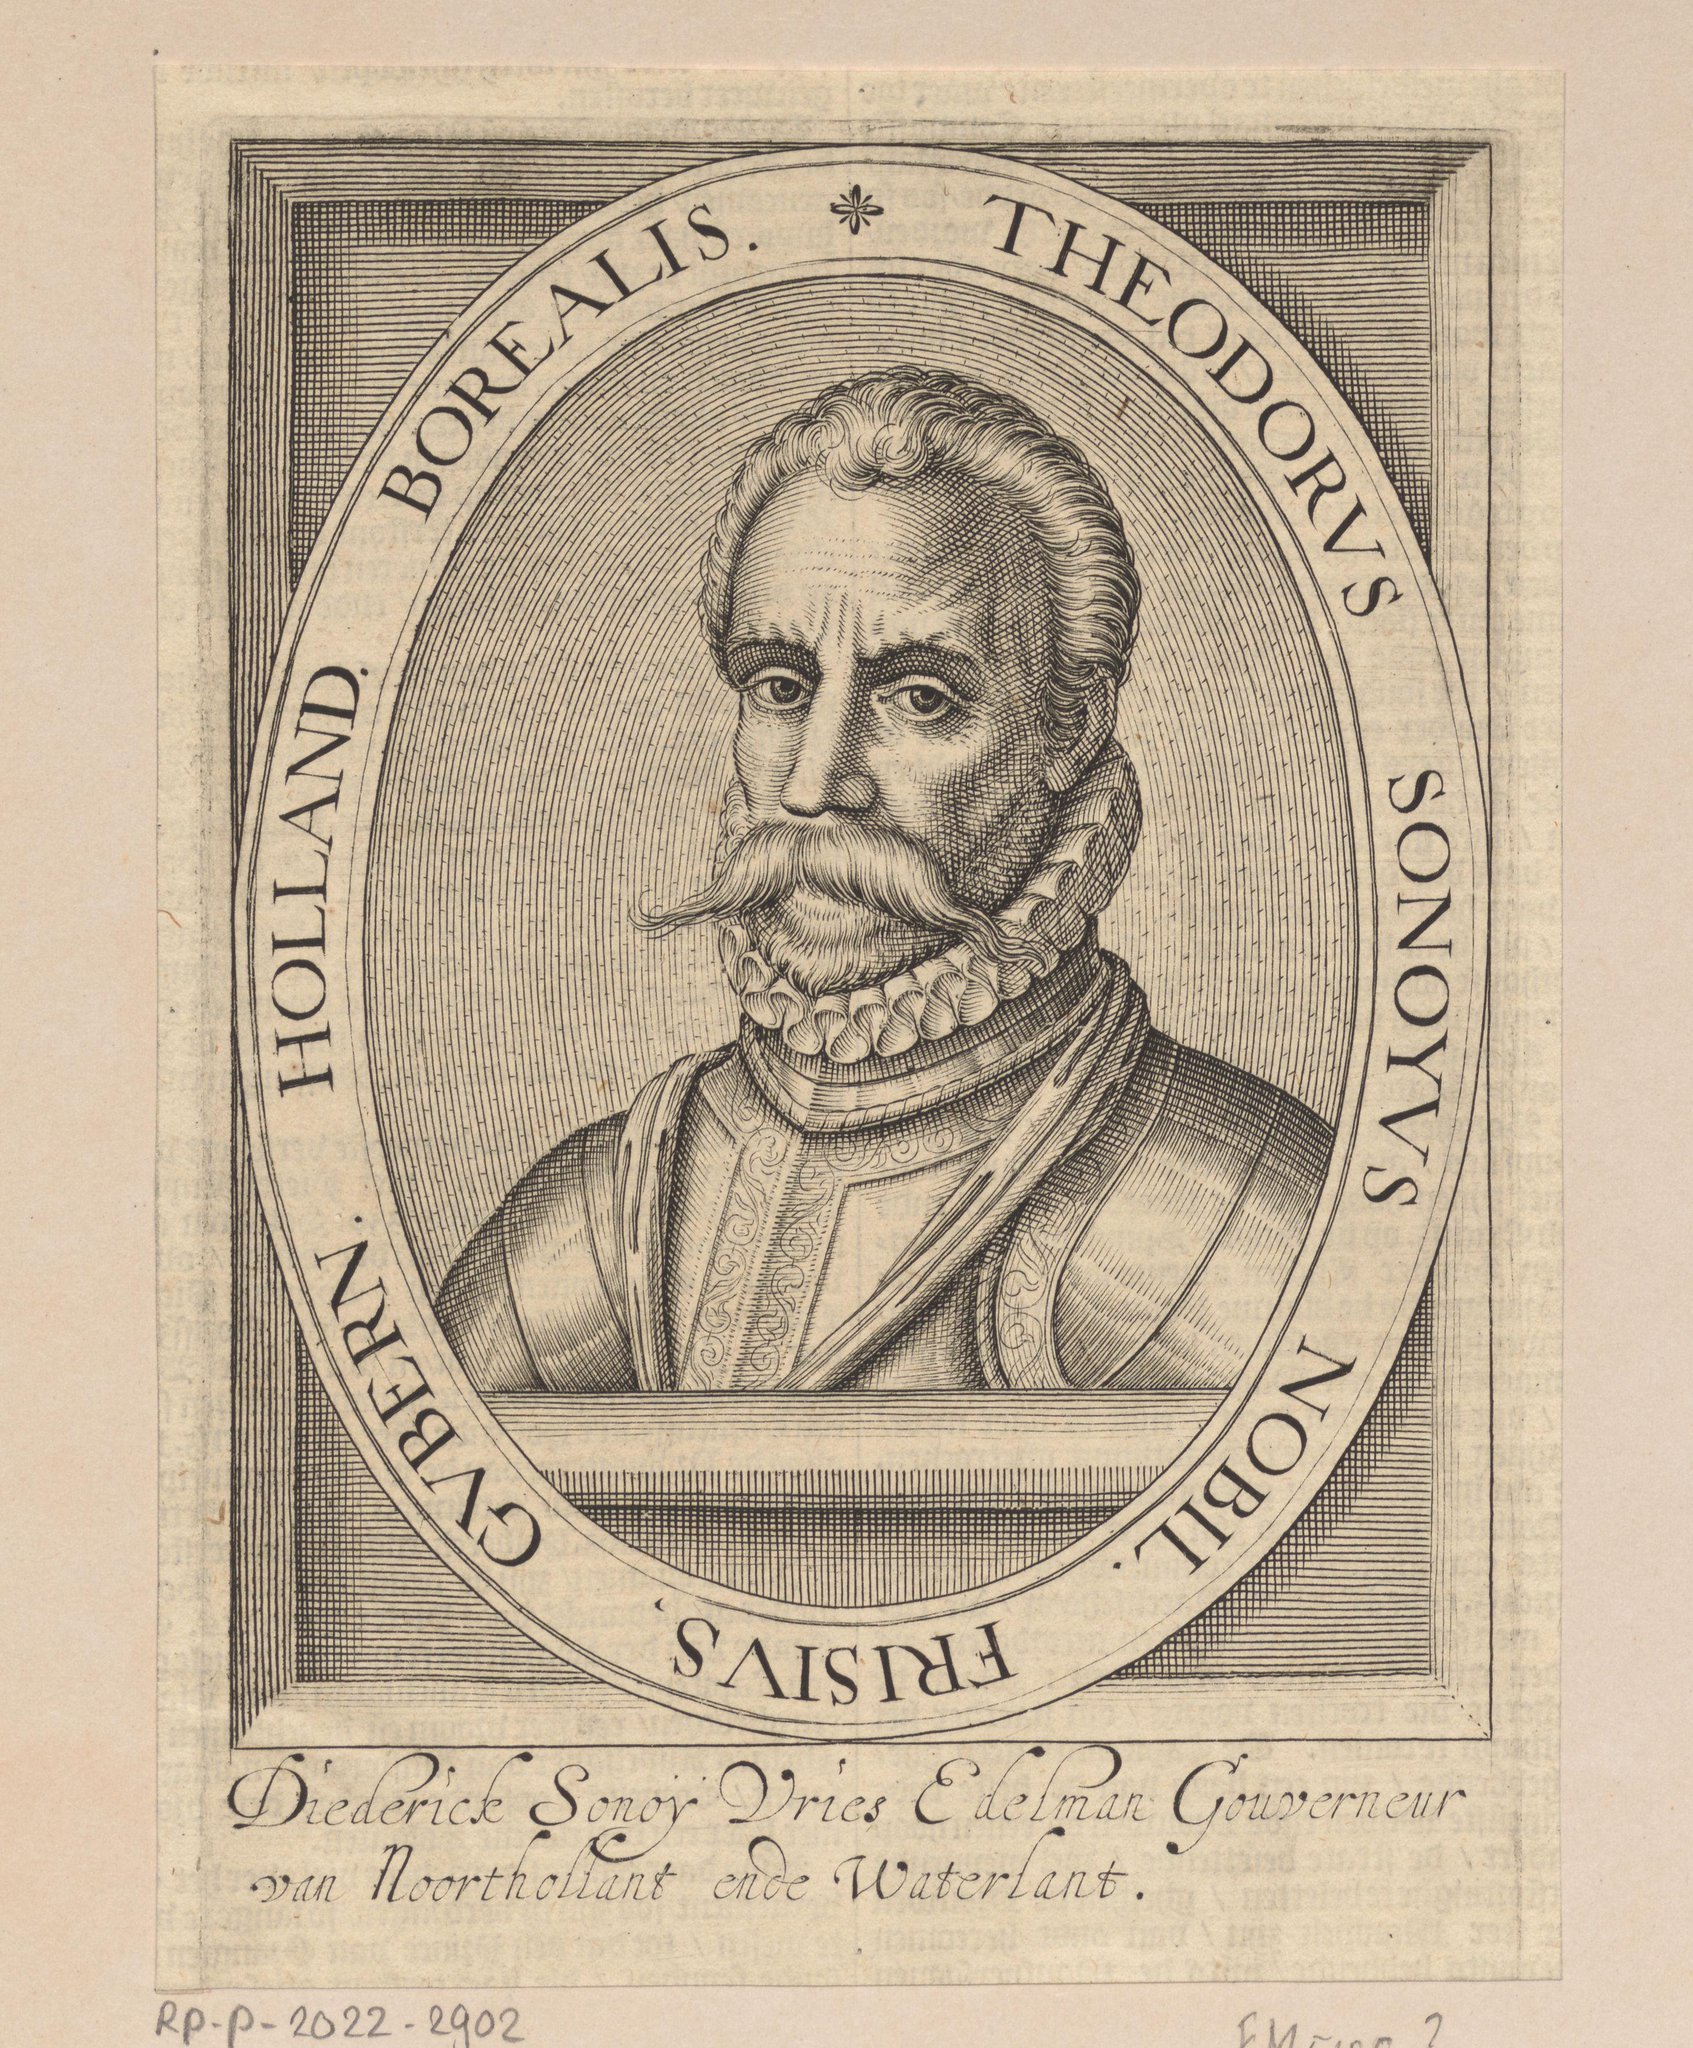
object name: print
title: Portret van Diederik van Sonoy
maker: Anonymous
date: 1600-1699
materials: paper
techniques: engraving, letterpress printing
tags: kalkar, historical persons, governor, etc. of province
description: Prent uit een onbekende publicatie. Prent met omlijsting gebruikt in: Meteren, Emanuel van. Eygentliche und vollkommene historische Beschreibung des Niderländischen Kriegs. Amsterdam: Johan Jansons, 1627.